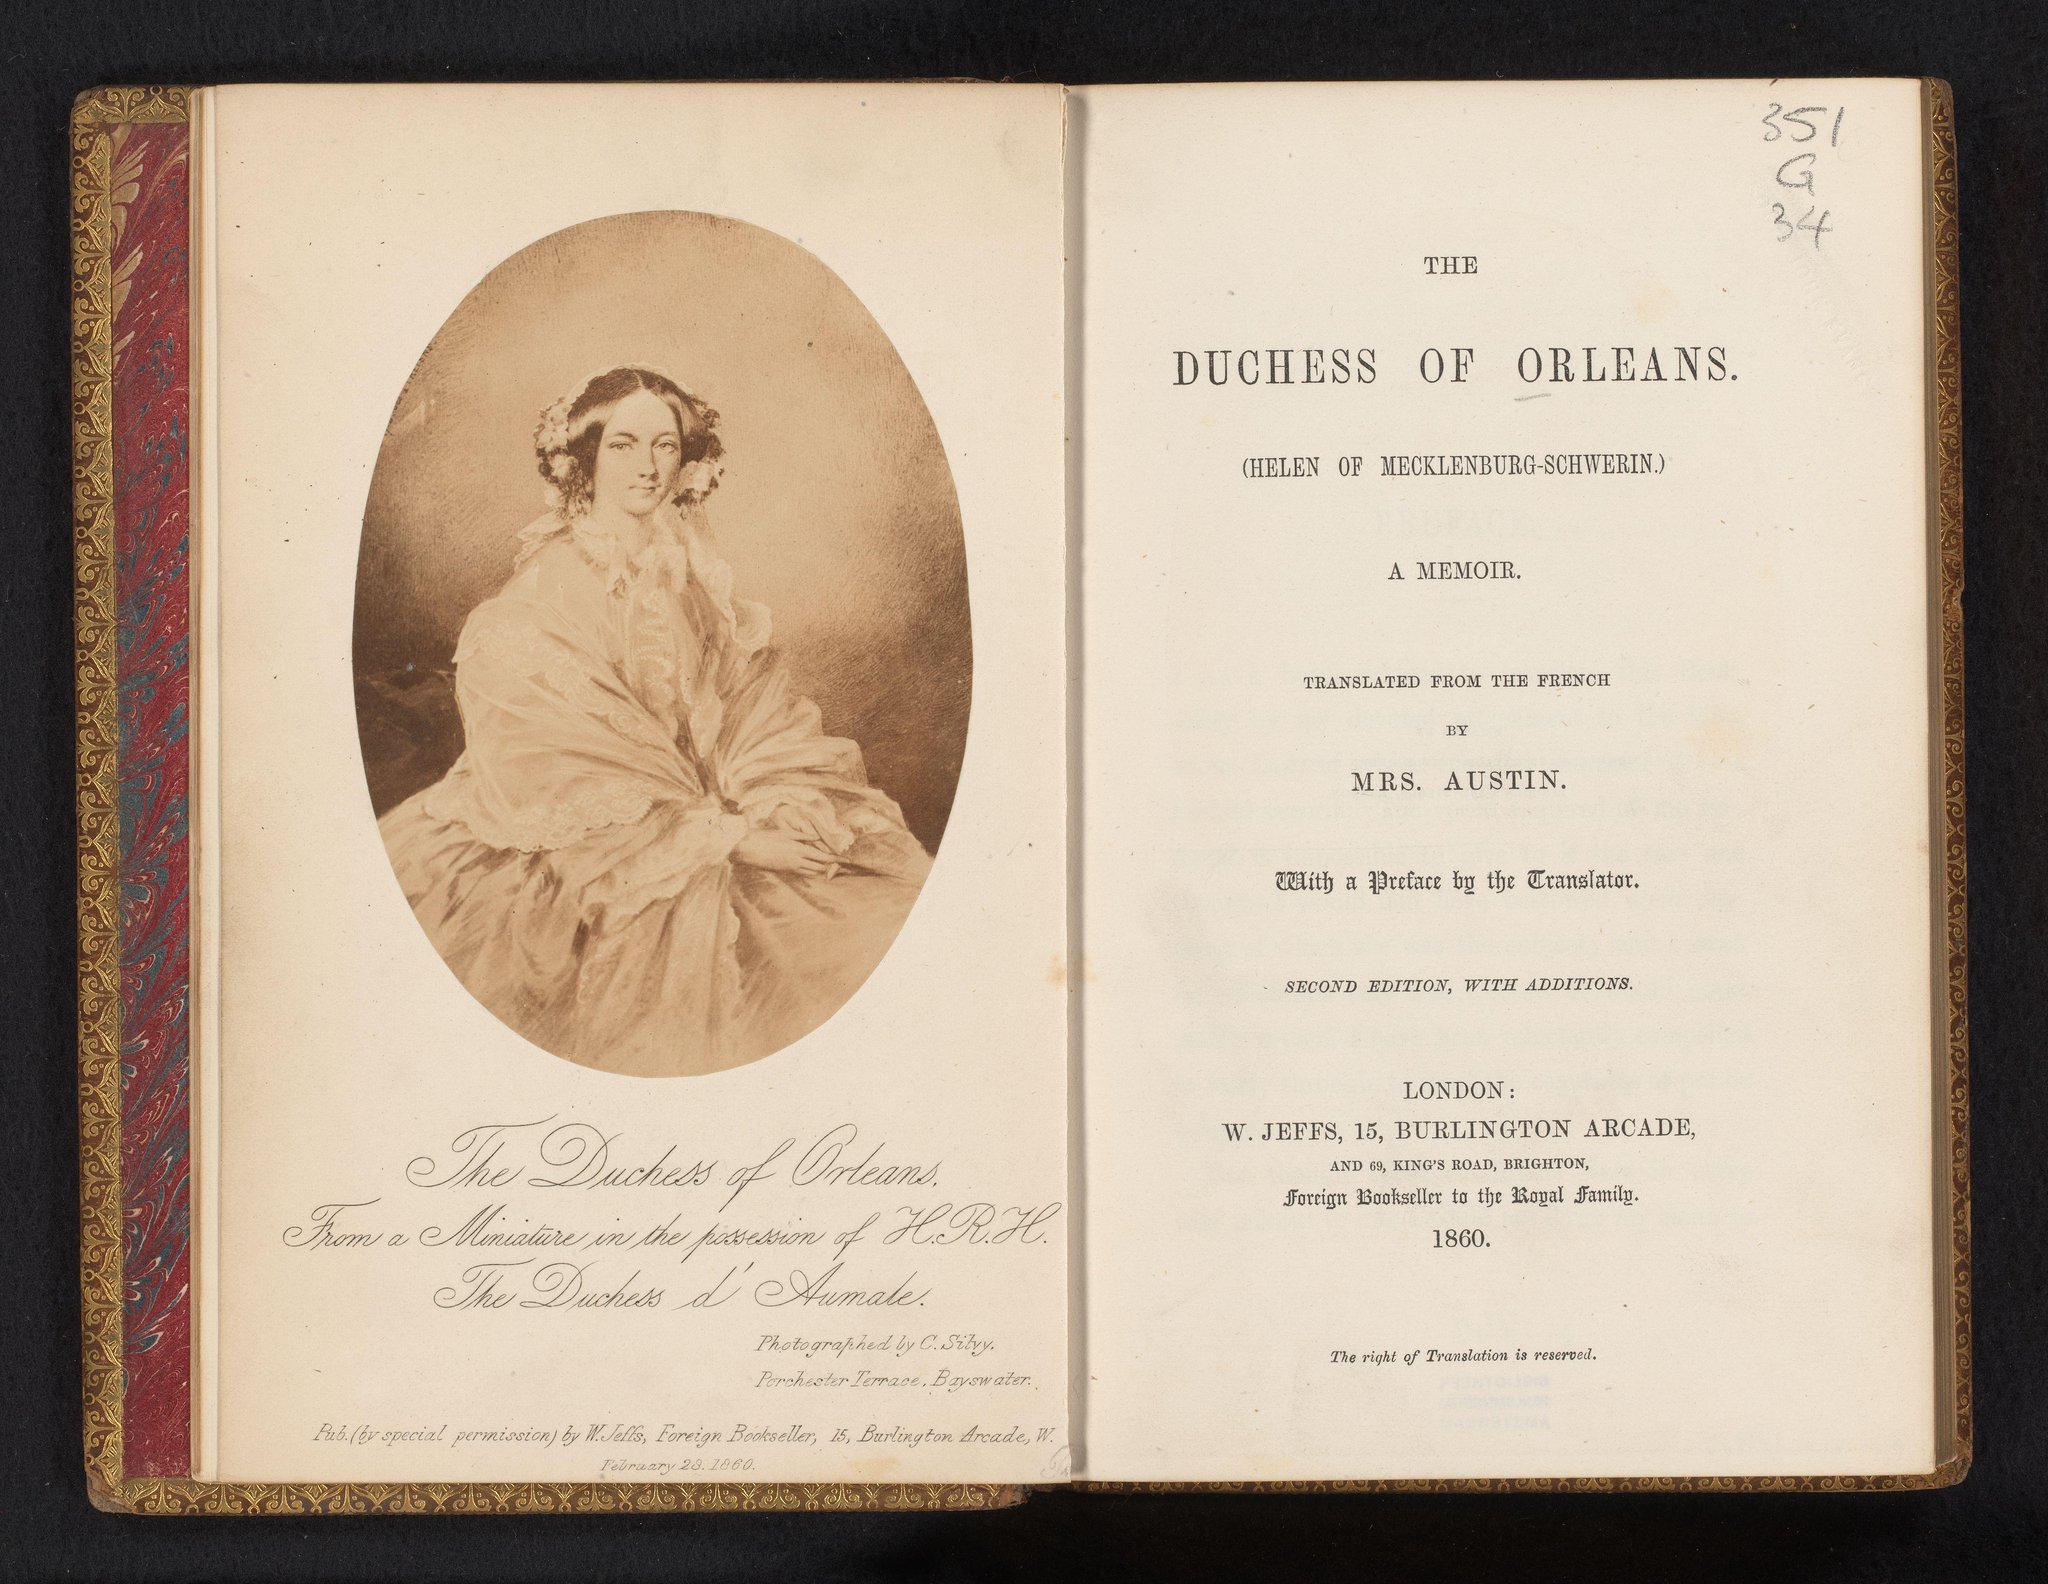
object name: reproduction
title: Fotoreproductie van een miniatuur van de hertogin van Orléans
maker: camille leon louis silvy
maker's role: fotograaf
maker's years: 1834-1910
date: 1855-1860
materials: paper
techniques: albumen print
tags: helene van mecklenburg-schwerin, historical persons - bb - woman, painting (including book-illumination, miniature-painting)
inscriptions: inscription: ‘From a Miniature in the possession of H.R.H./ The Duchess d'Aumale./ Photographed by C. Silvy./ Porchester Terrace, Bayswater./ Pub. (by special permission) by W. Jeffs, Foreign Bookseller, 15, Burlington Arcade, W./ February 28. 1860.’